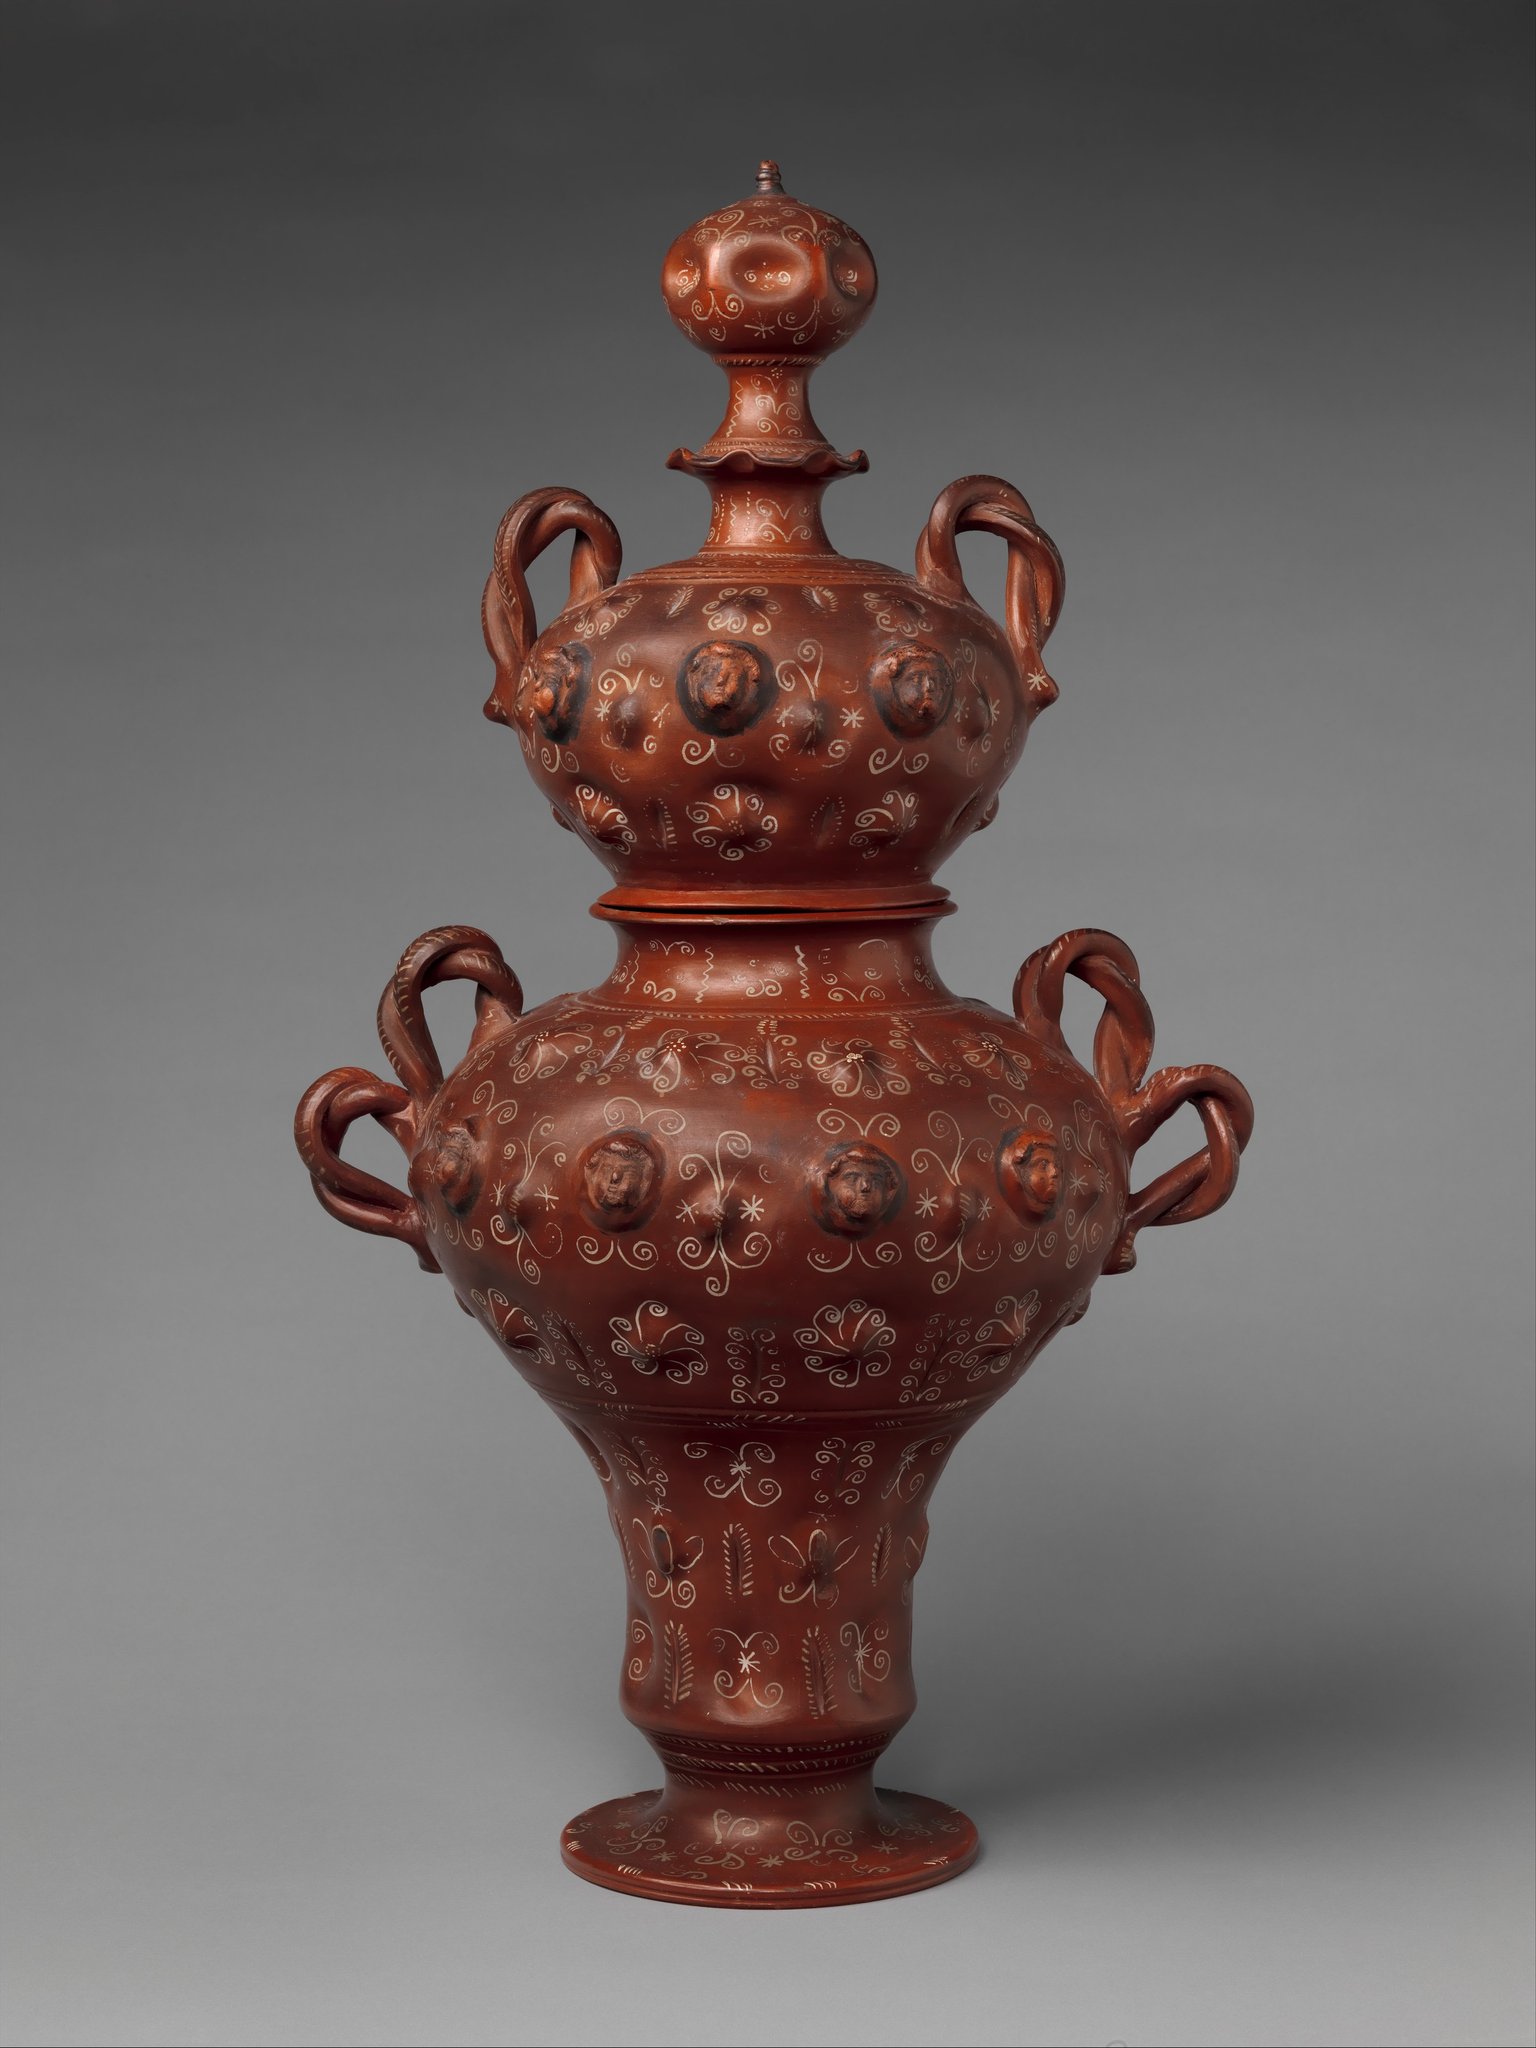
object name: covered jar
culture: mexican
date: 1675-1700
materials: earthenware, paint, silver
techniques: burnishing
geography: mexico